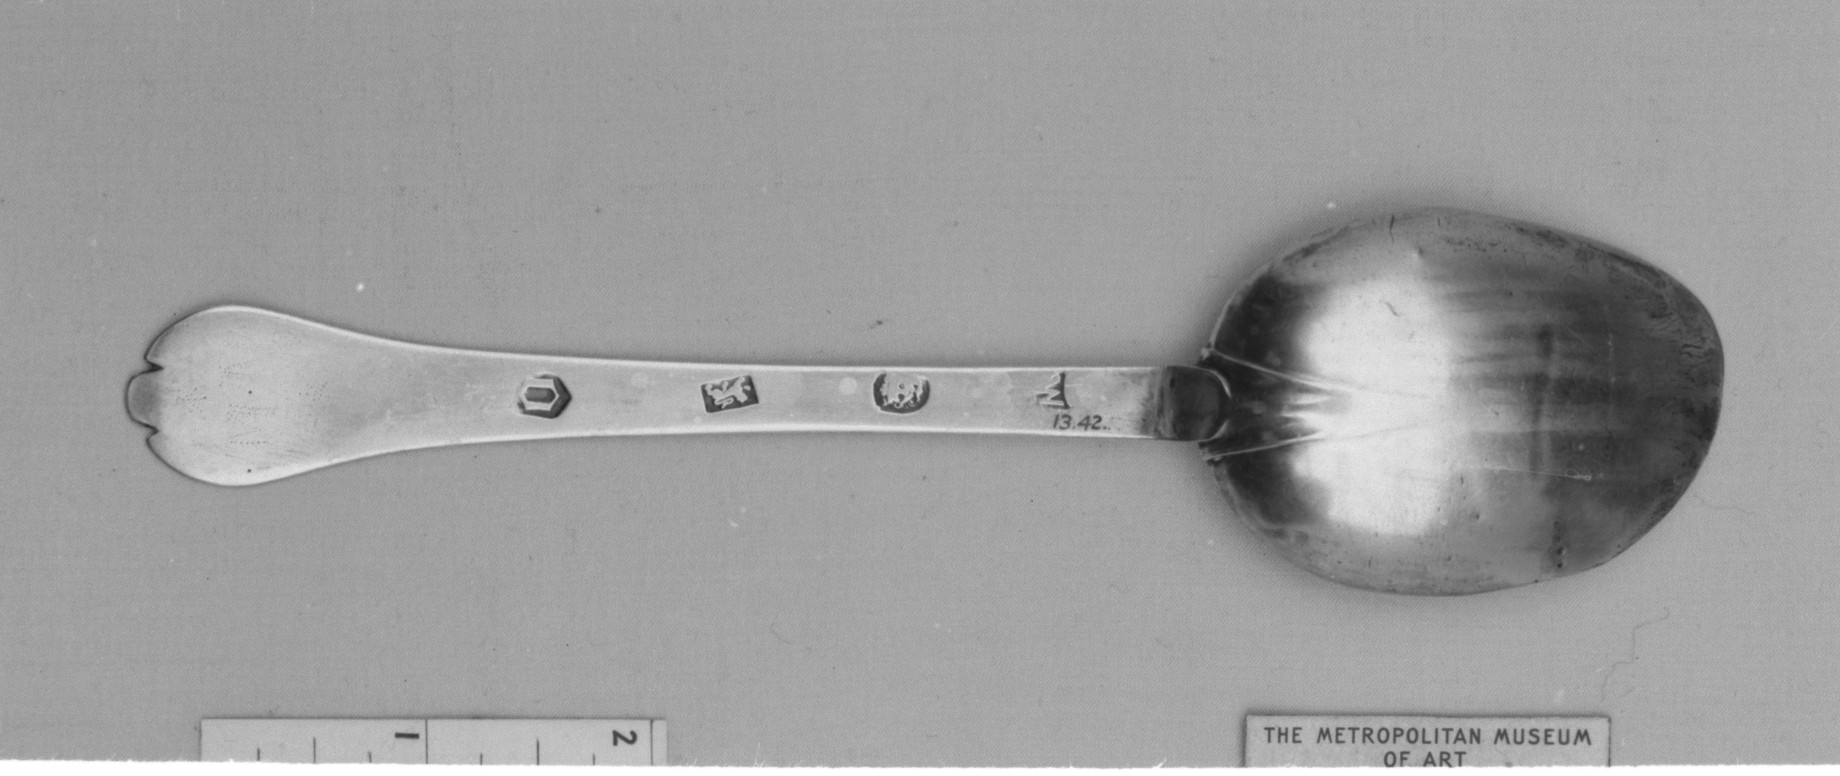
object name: spoon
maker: william scarlett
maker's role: maker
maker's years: 1689-1697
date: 1691-1692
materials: silver